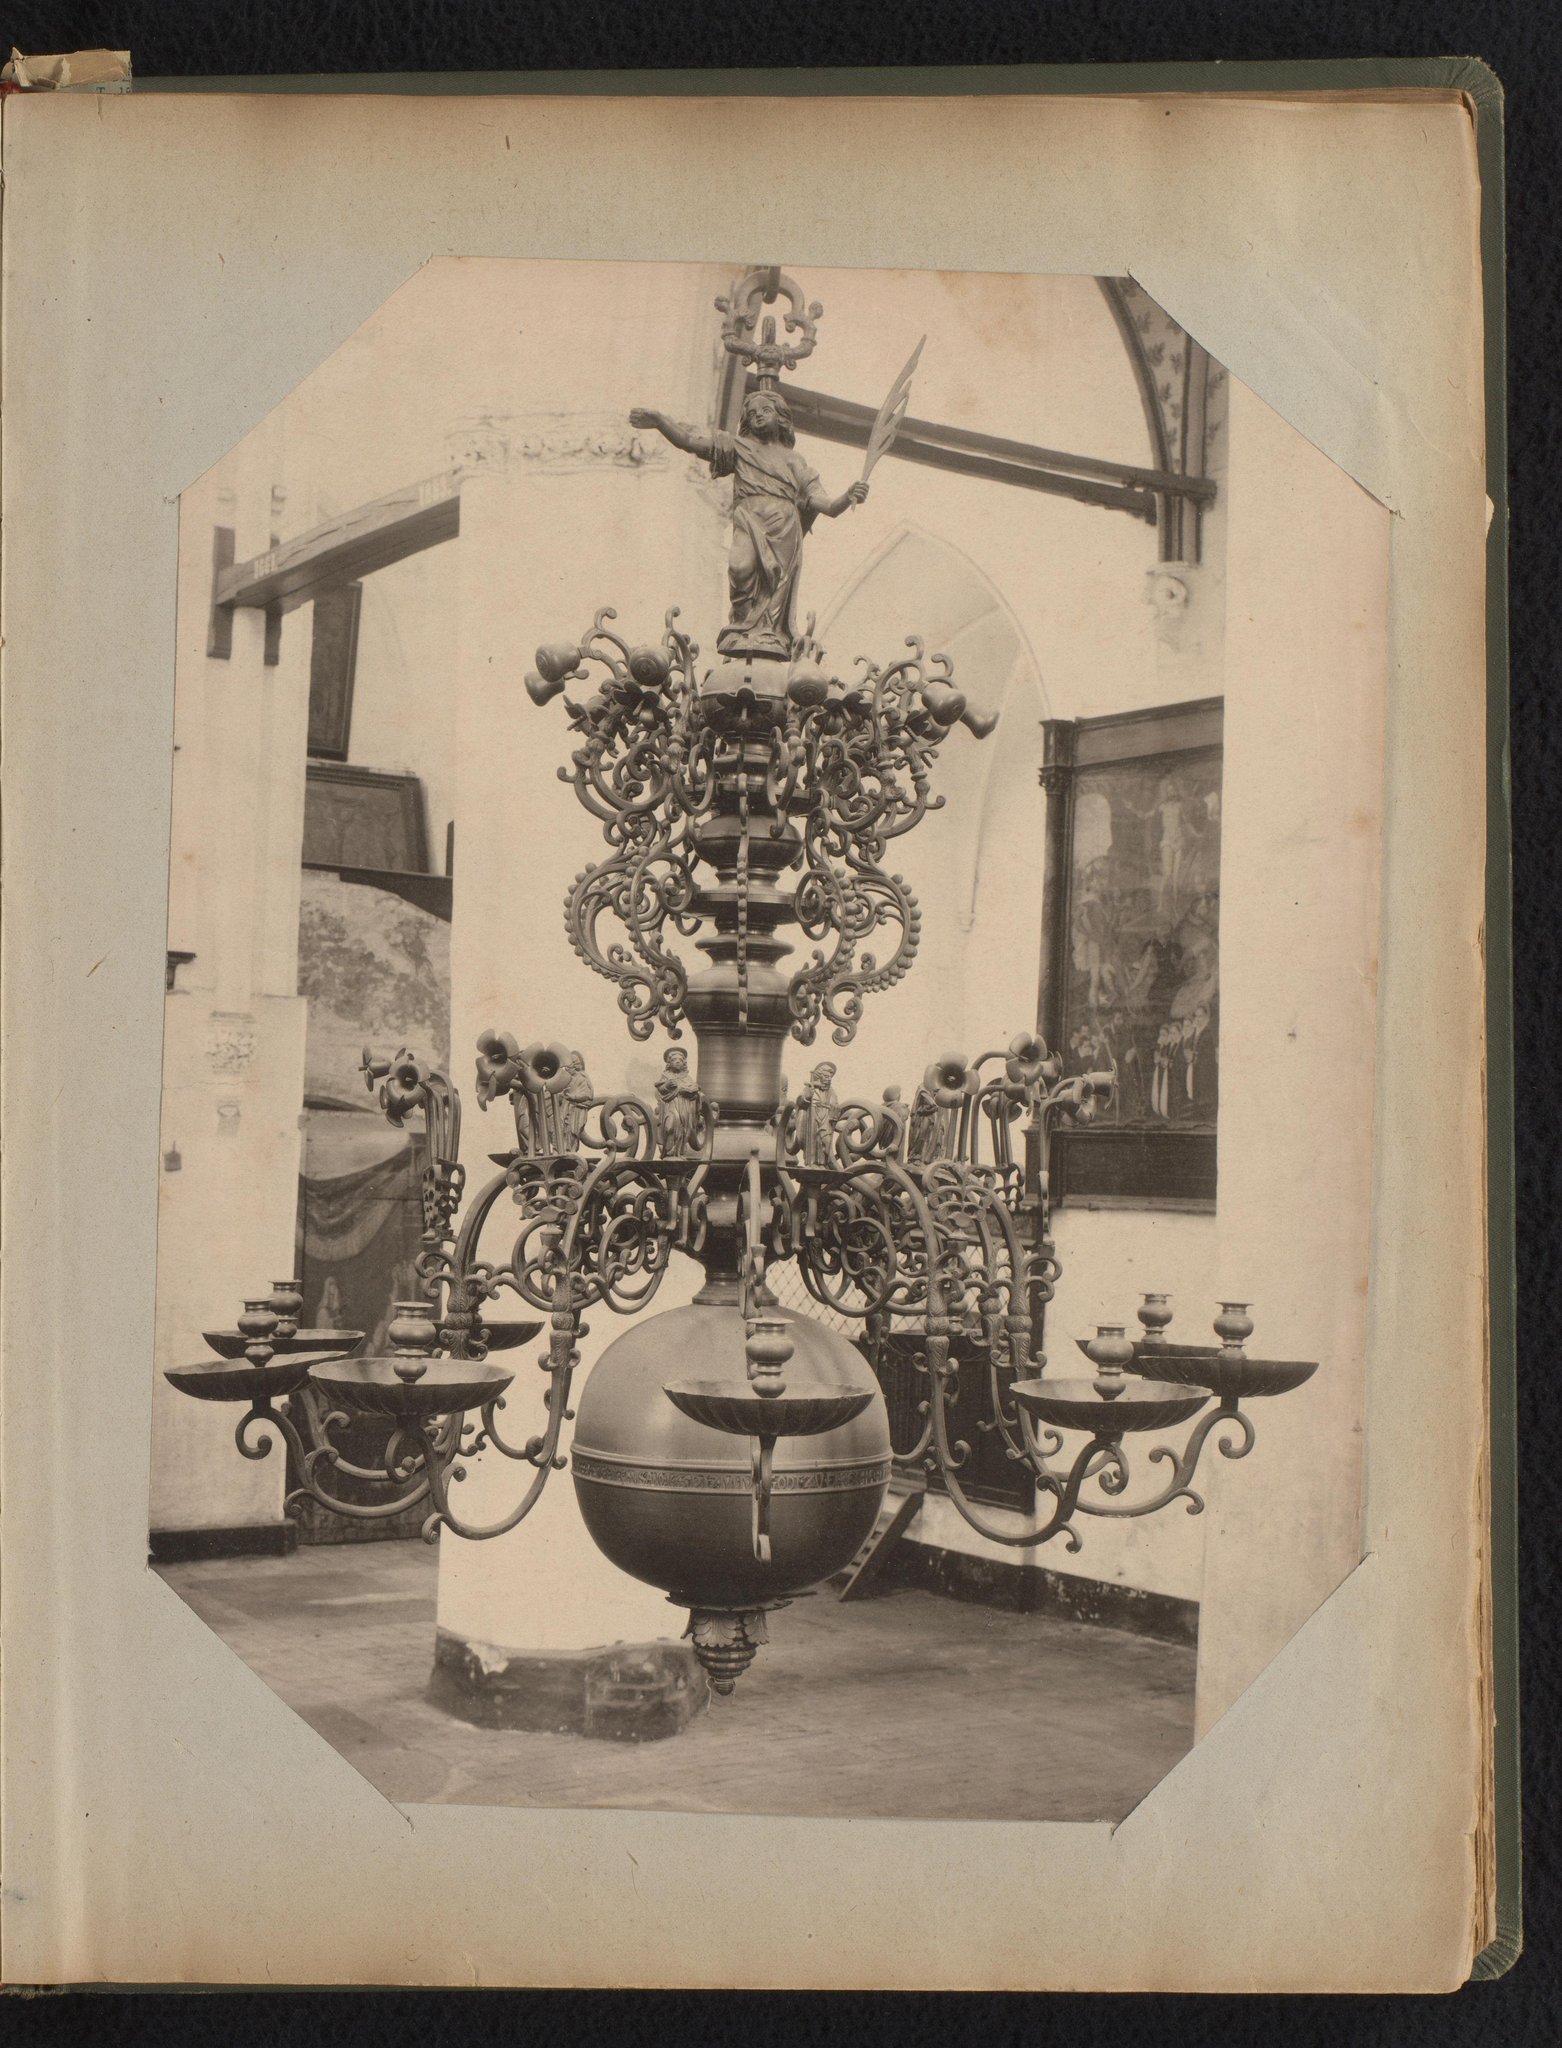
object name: photograph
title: Tienarmige hangende bronzen kandelaar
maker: Anonymous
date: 1860-1900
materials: canvas, cardboard, paper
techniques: matte daylight collodion silver print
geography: netherlands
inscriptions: annotation: ‘Chandeller emive foundu de l'ann 1665 St Catarine a Anbeck.’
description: Tienarmige hangende bronzen kandelaar gedecoreerd met opstaande bloemen. Bovenaan de kandelaar staat een engel met een boomblad in de hand.